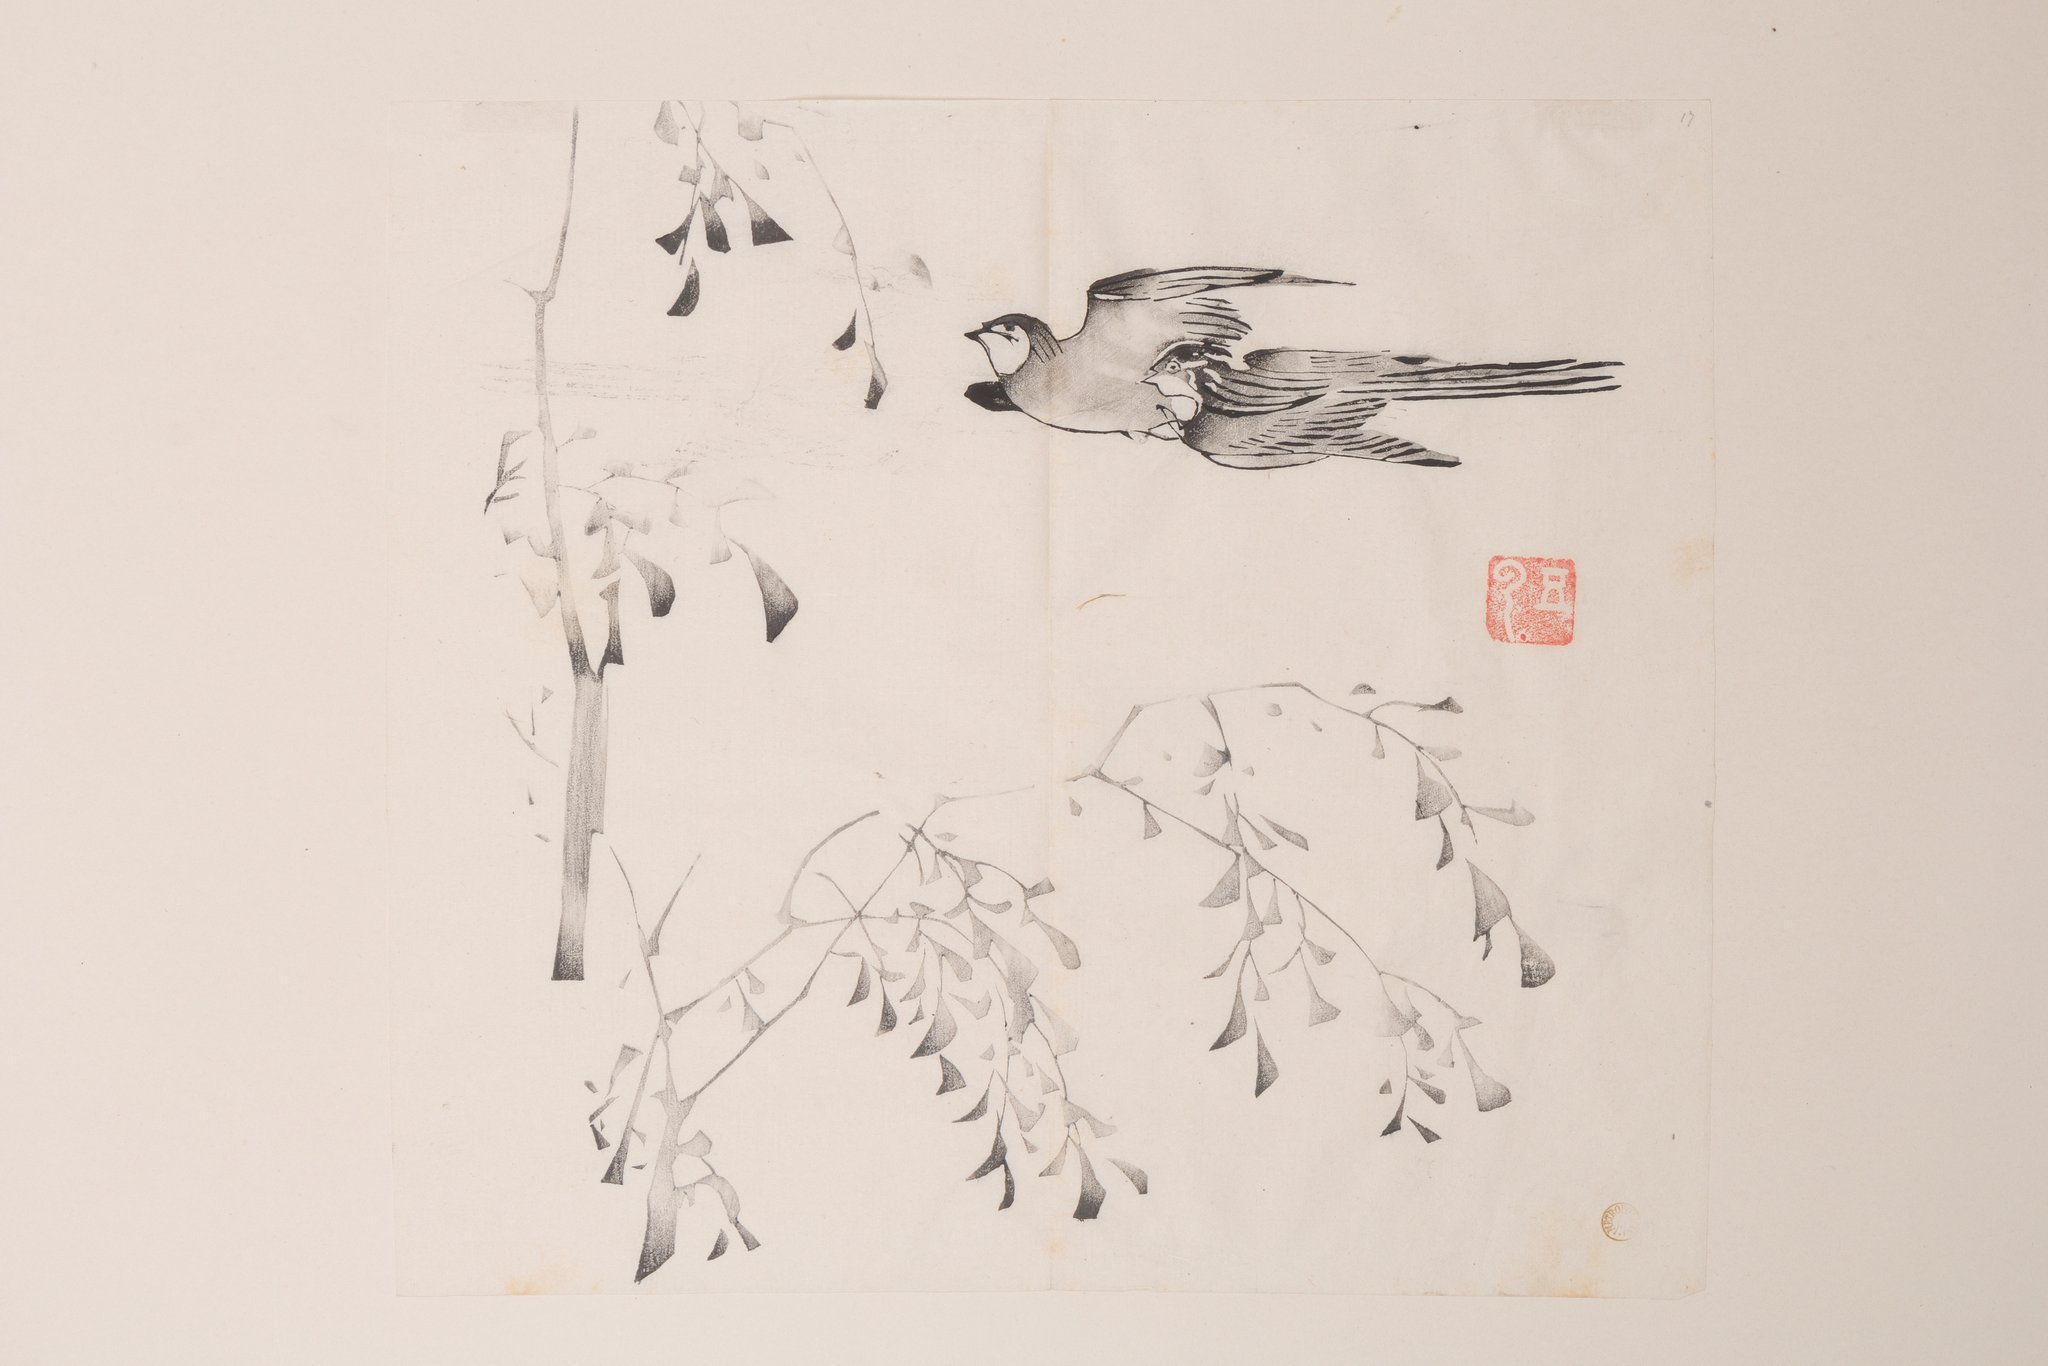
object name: print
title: Page from Shi Zhu Zhai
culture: chinese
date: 1736-1795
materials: ink, paper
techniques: polychrome, woodblock print